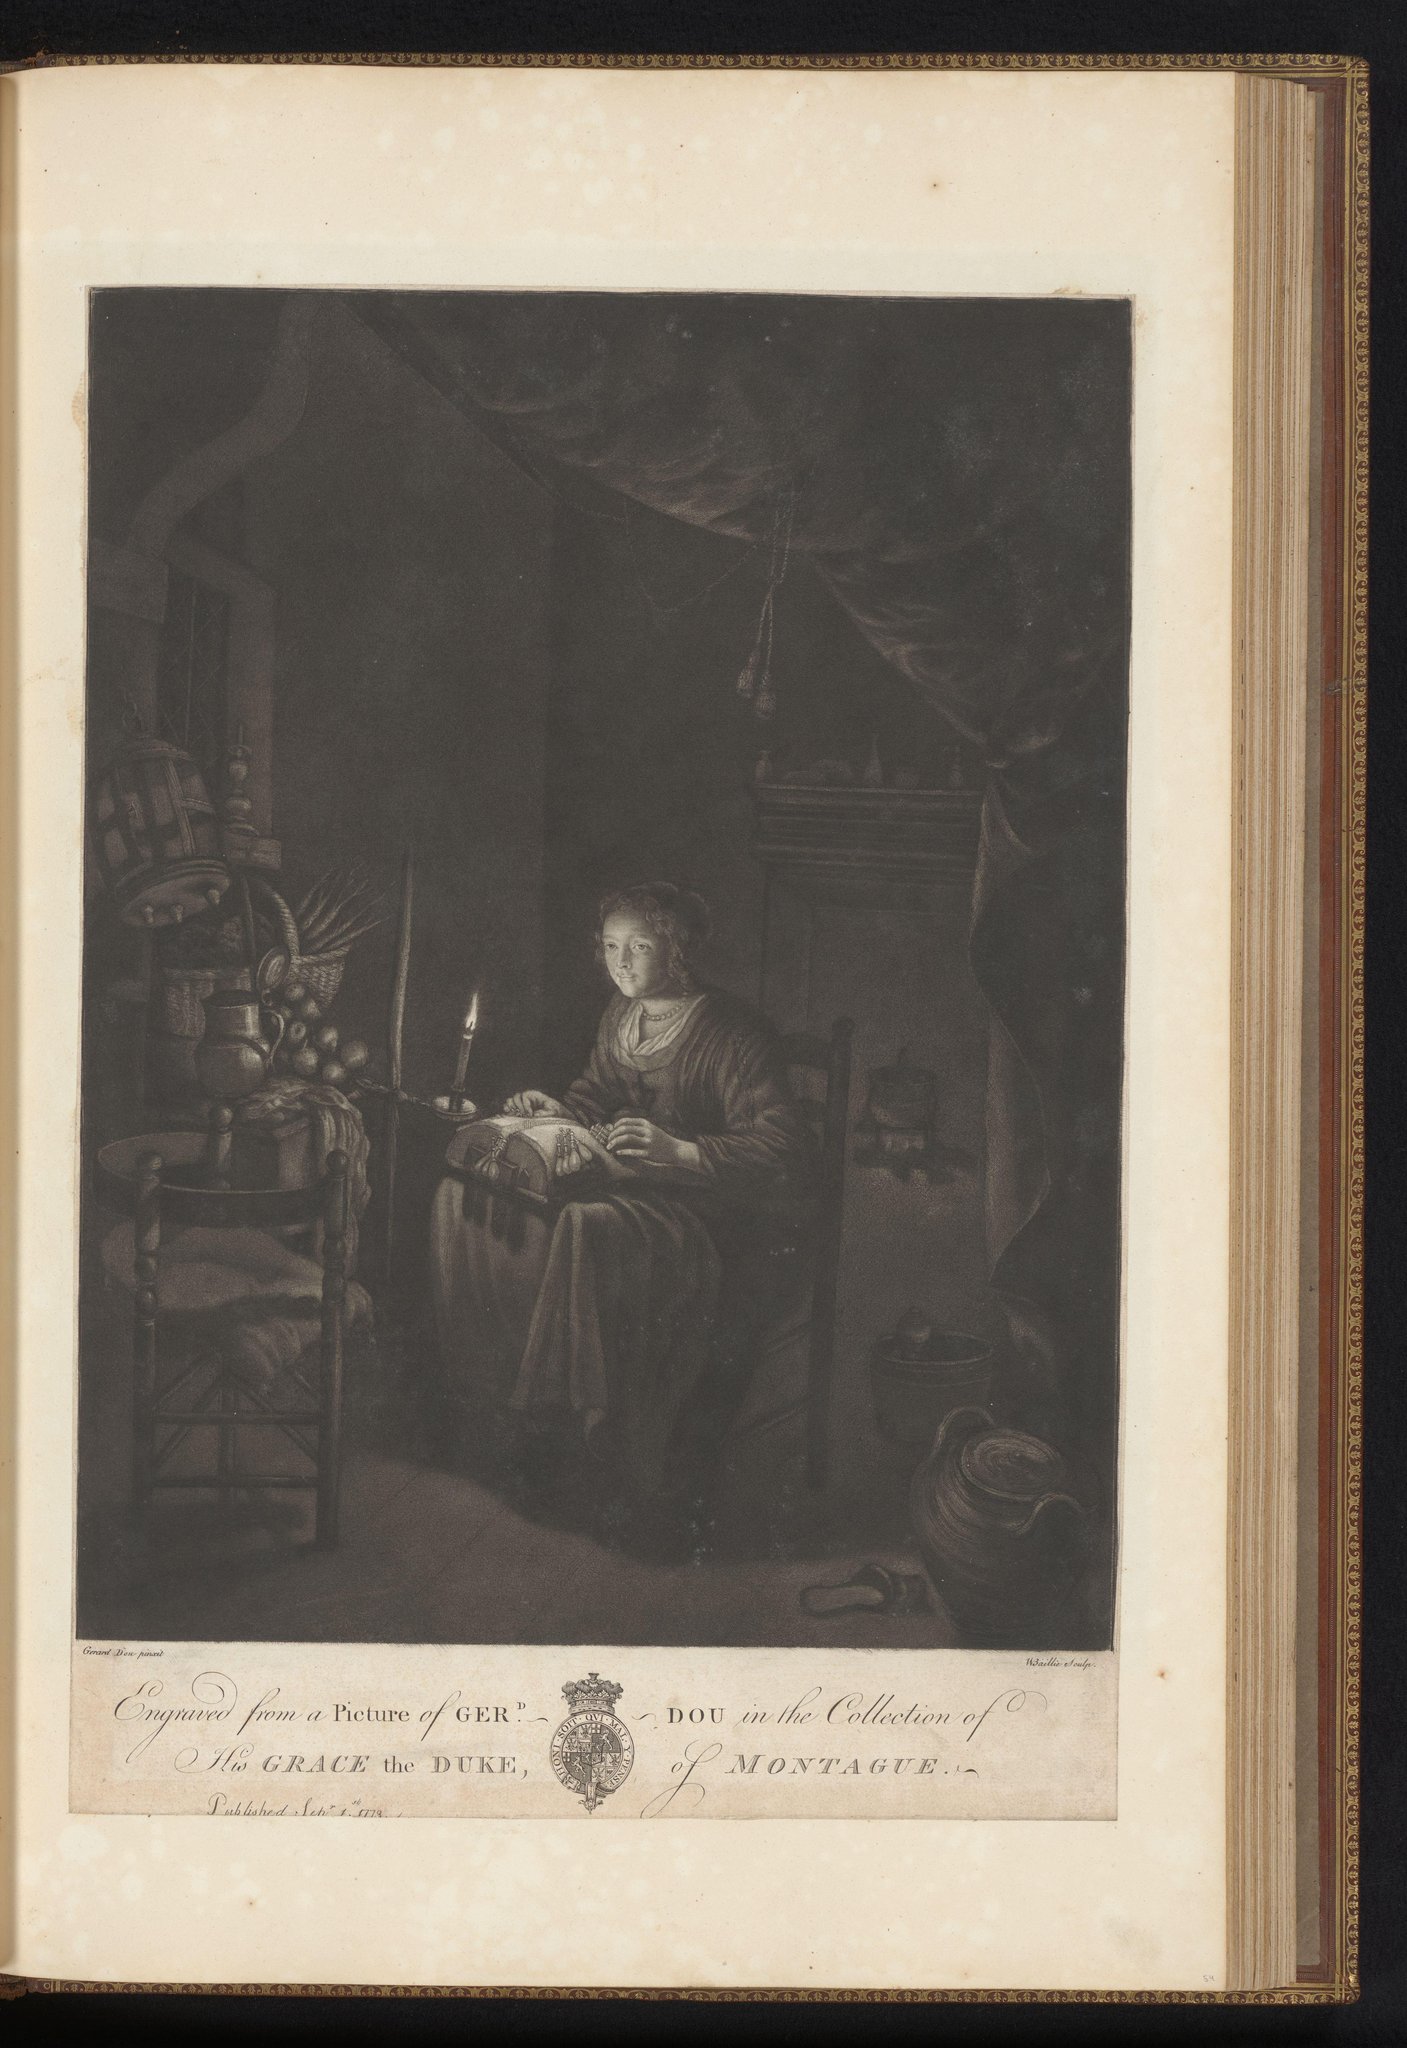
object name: album leaf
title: Kantwerkster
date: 1773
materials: paper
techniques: etching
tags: lace-making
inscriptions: date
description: Een jonge vrouw zit in een stoel met haar kantwerk op haar schoot. De prent maakt deel uit van een album.